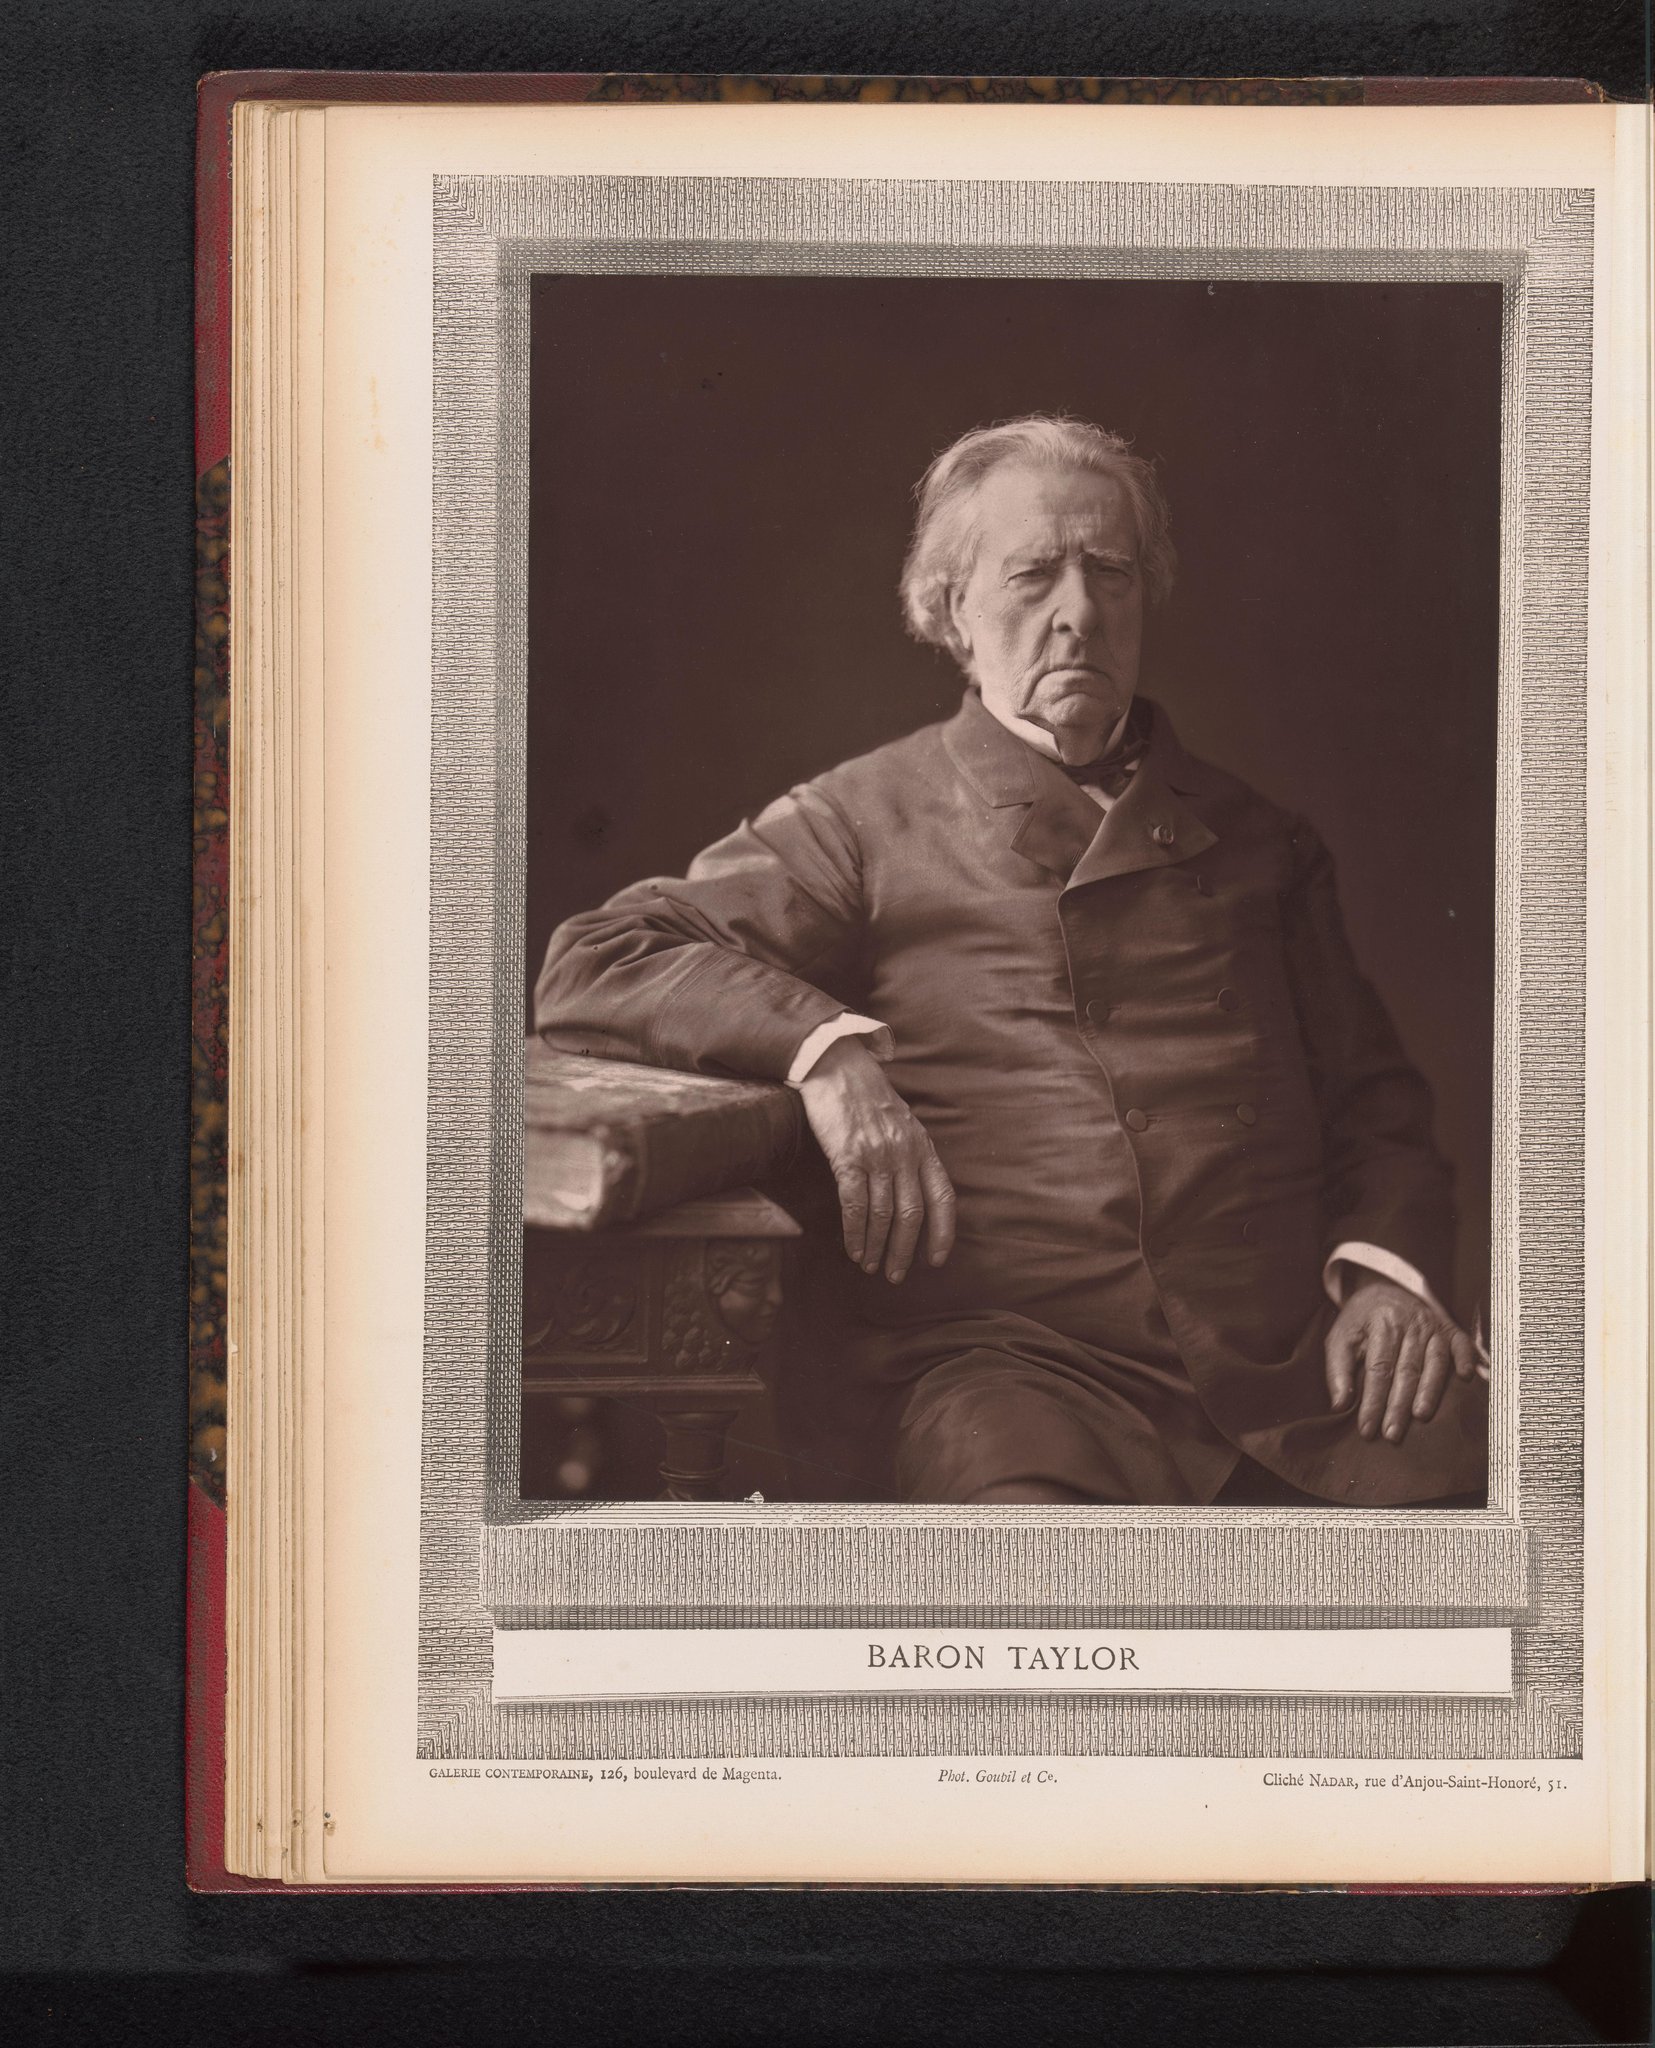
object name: photomechanical print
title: Baron Taylor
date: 1872-1877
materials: paper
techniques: woodburytype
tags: brussels, paris, politician, isidore justin séverin baron taylor, adult man, historical persons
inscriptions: inscription: ‘Galerie Contemporaine, 126, boulevard de Magenta.’